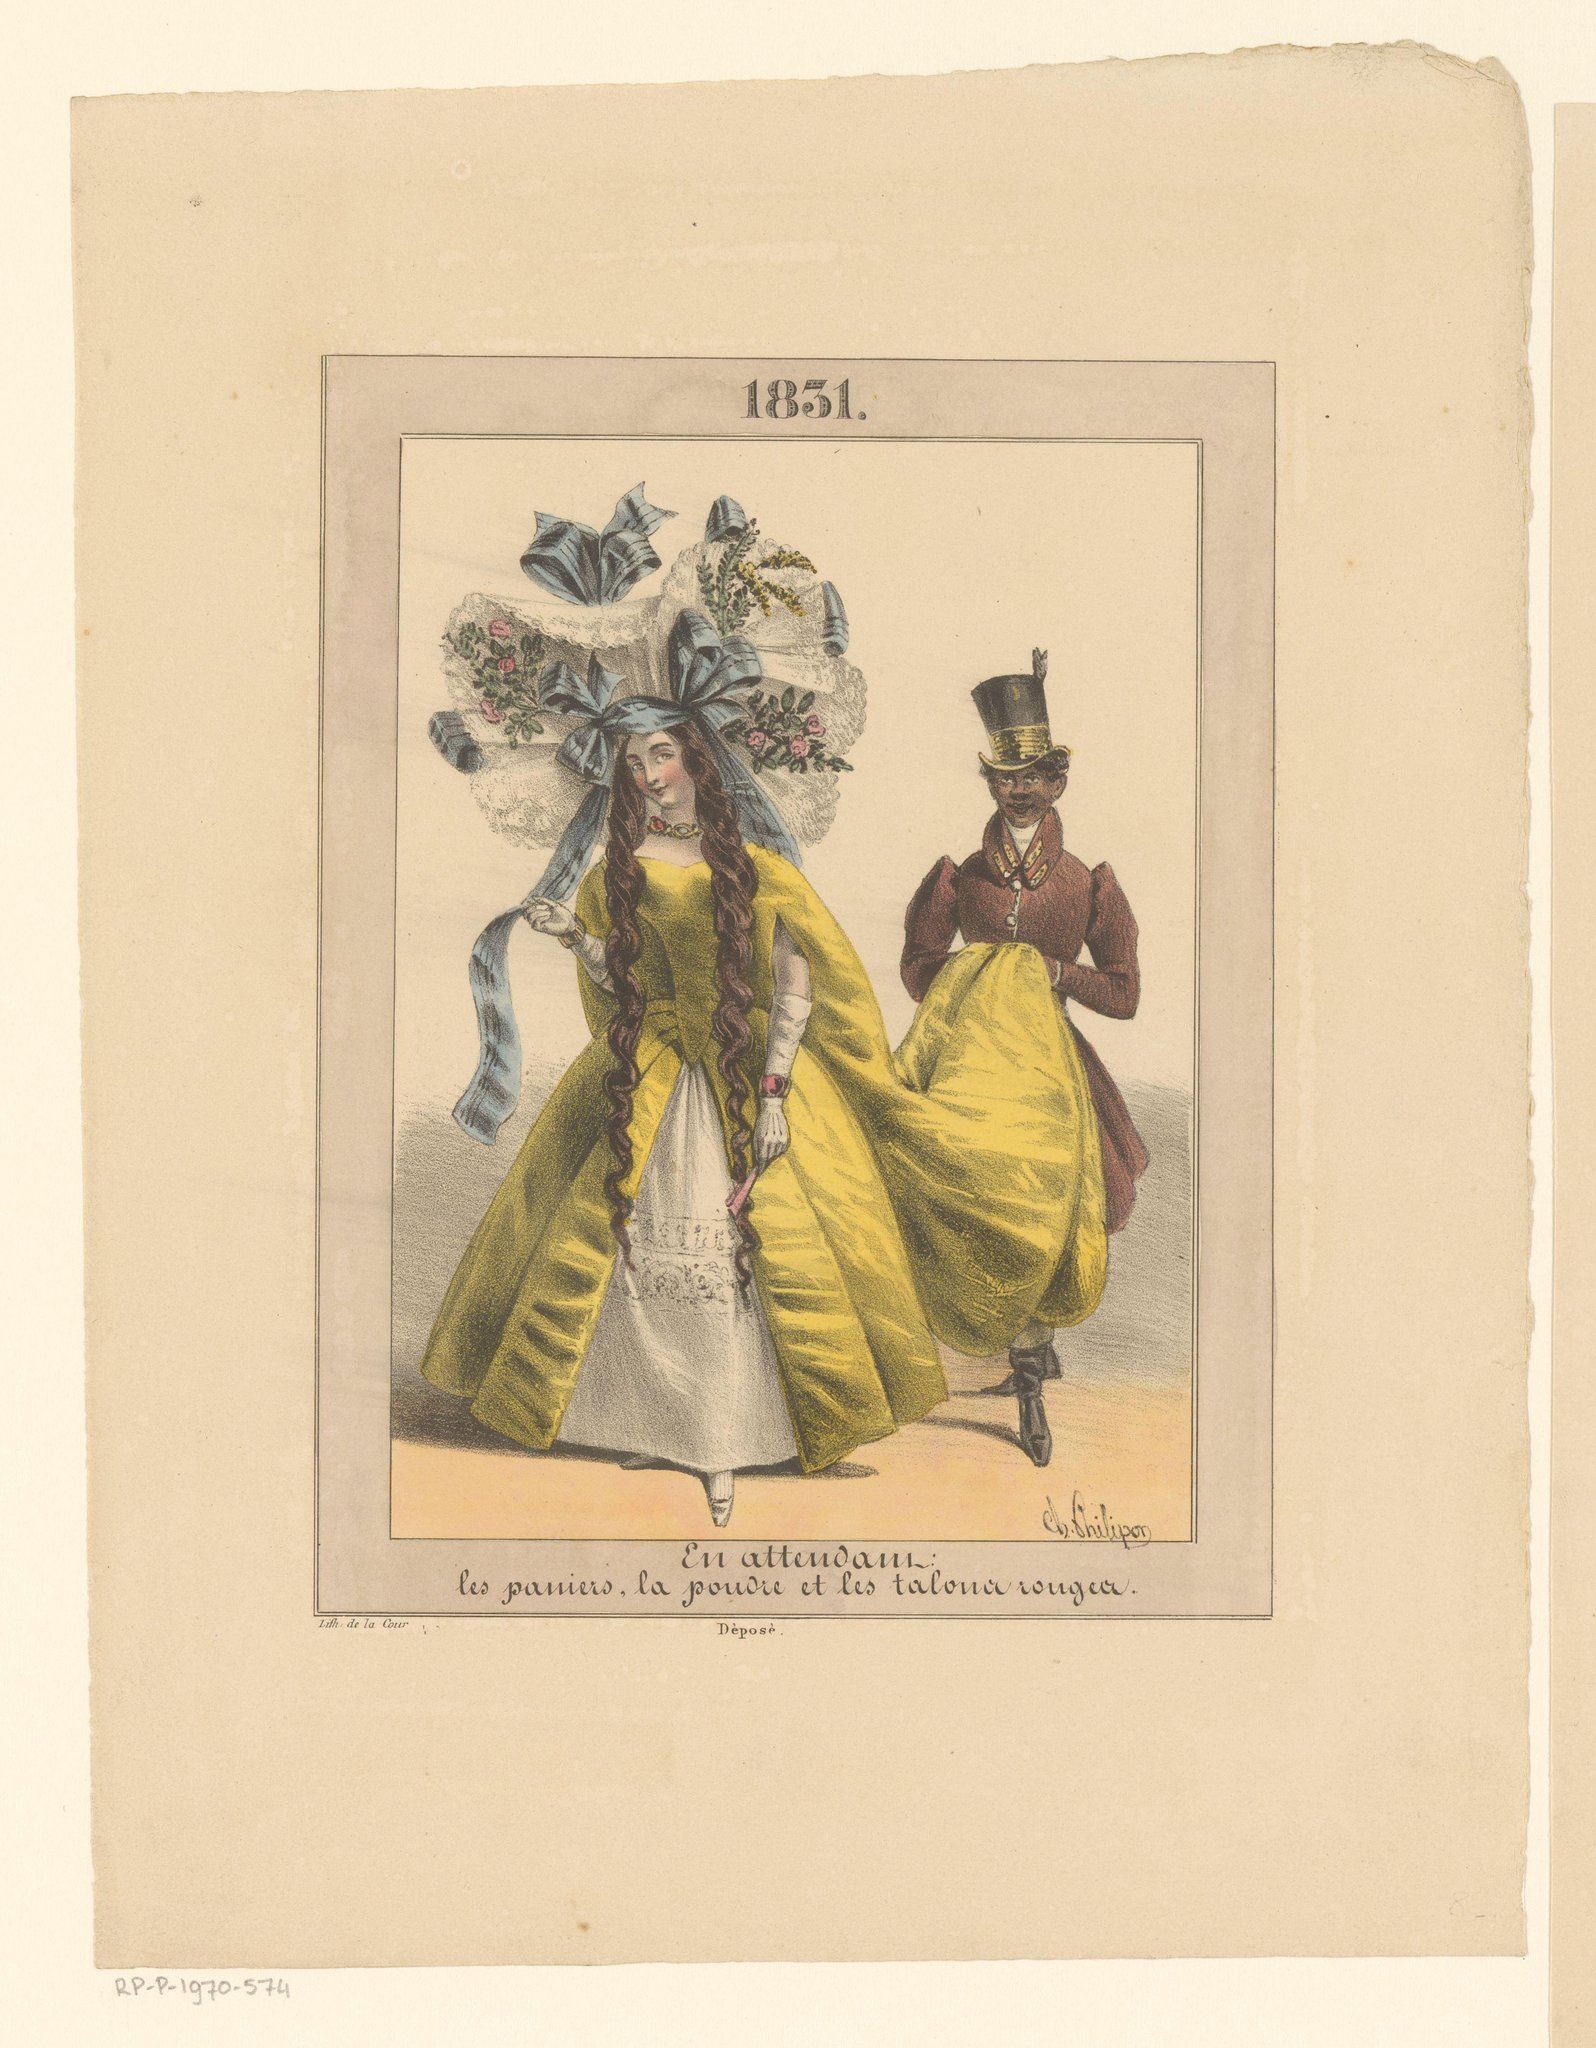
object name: cartoon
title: En attendant: les paniers, la poudre et les talons rouges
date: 1831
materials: paper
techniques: hand coloring, lithograph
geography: paris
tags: fashion, clothing, head-gear, adult man, maid ~ house personnel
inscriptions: collector's mark: Lugt 2228